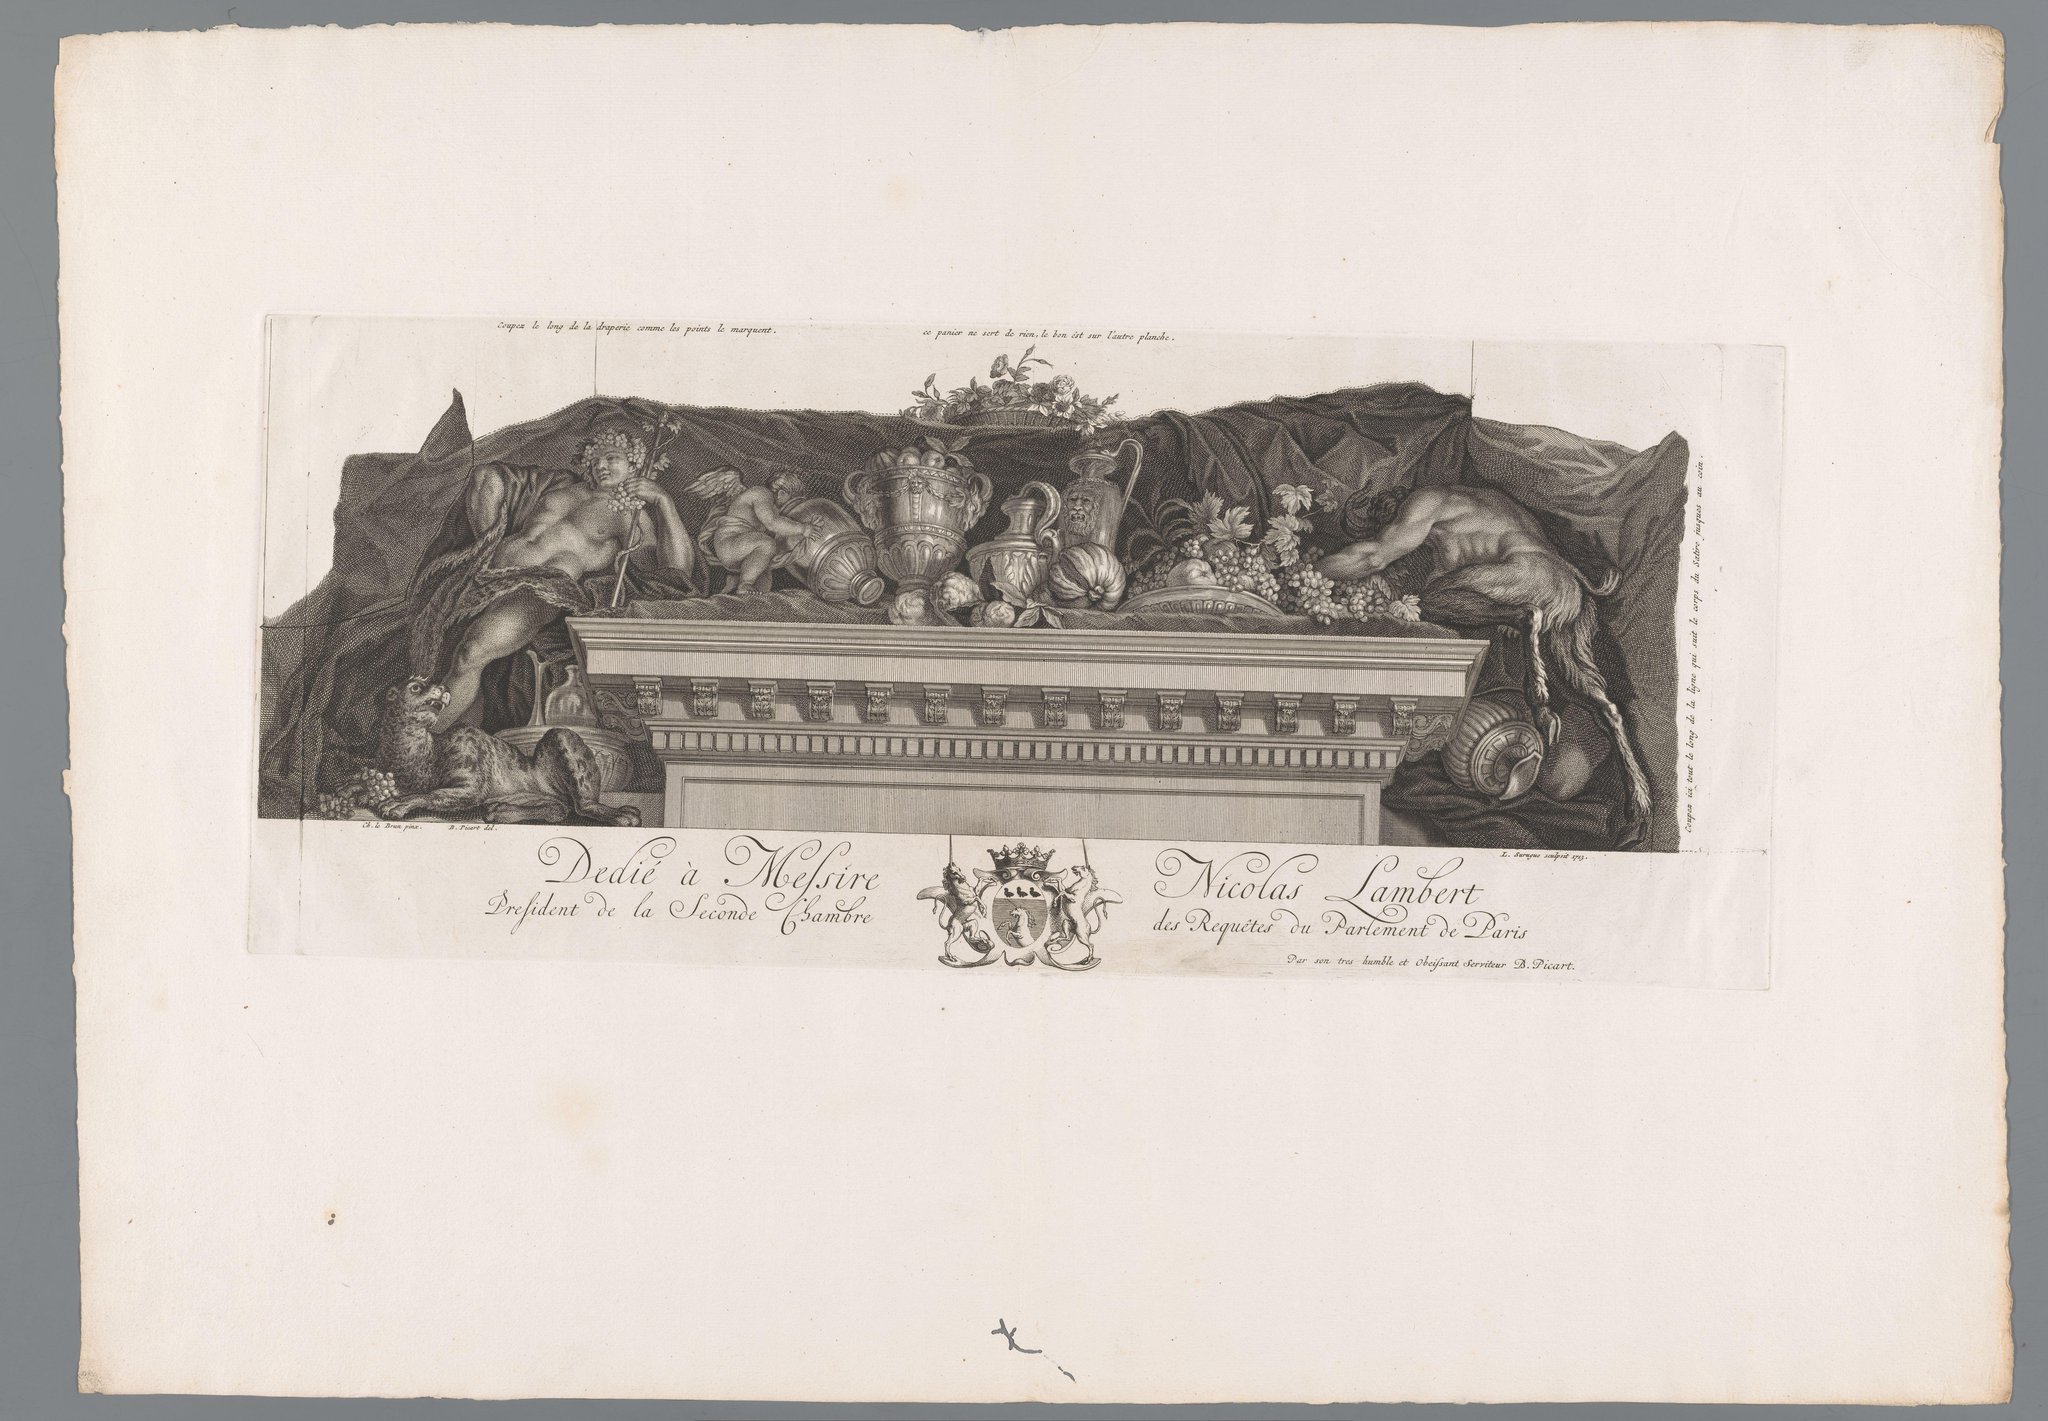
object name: print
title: La galerie de monsr. le president Lambert representant l'Apotheose d'Hercule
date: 1713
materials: paper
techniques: engraving, etching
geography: paris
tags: attributes of bacchus: vine, (story of) bacchus (dionysus), liber, (story of) pan, (decorated) ceiling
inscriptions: collector's mark: Lugt 2228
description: Kroonlijst geflankeerd door Bacchus, met de thyrsus in zijn hand, en Pan, op de rug gezien. Langs de randen instructies voor het monteren van de prent aan andere prenten. Onderaan een opdracht in het Frans aan Nicolas Lambert en in het midden zijn wapenschild. Prent maakt deel uit van een serie prenten, die samen het geschilderde plafond met de Apotheose van Hercules in het Hôtel Lambert te Parijs voorstellen.